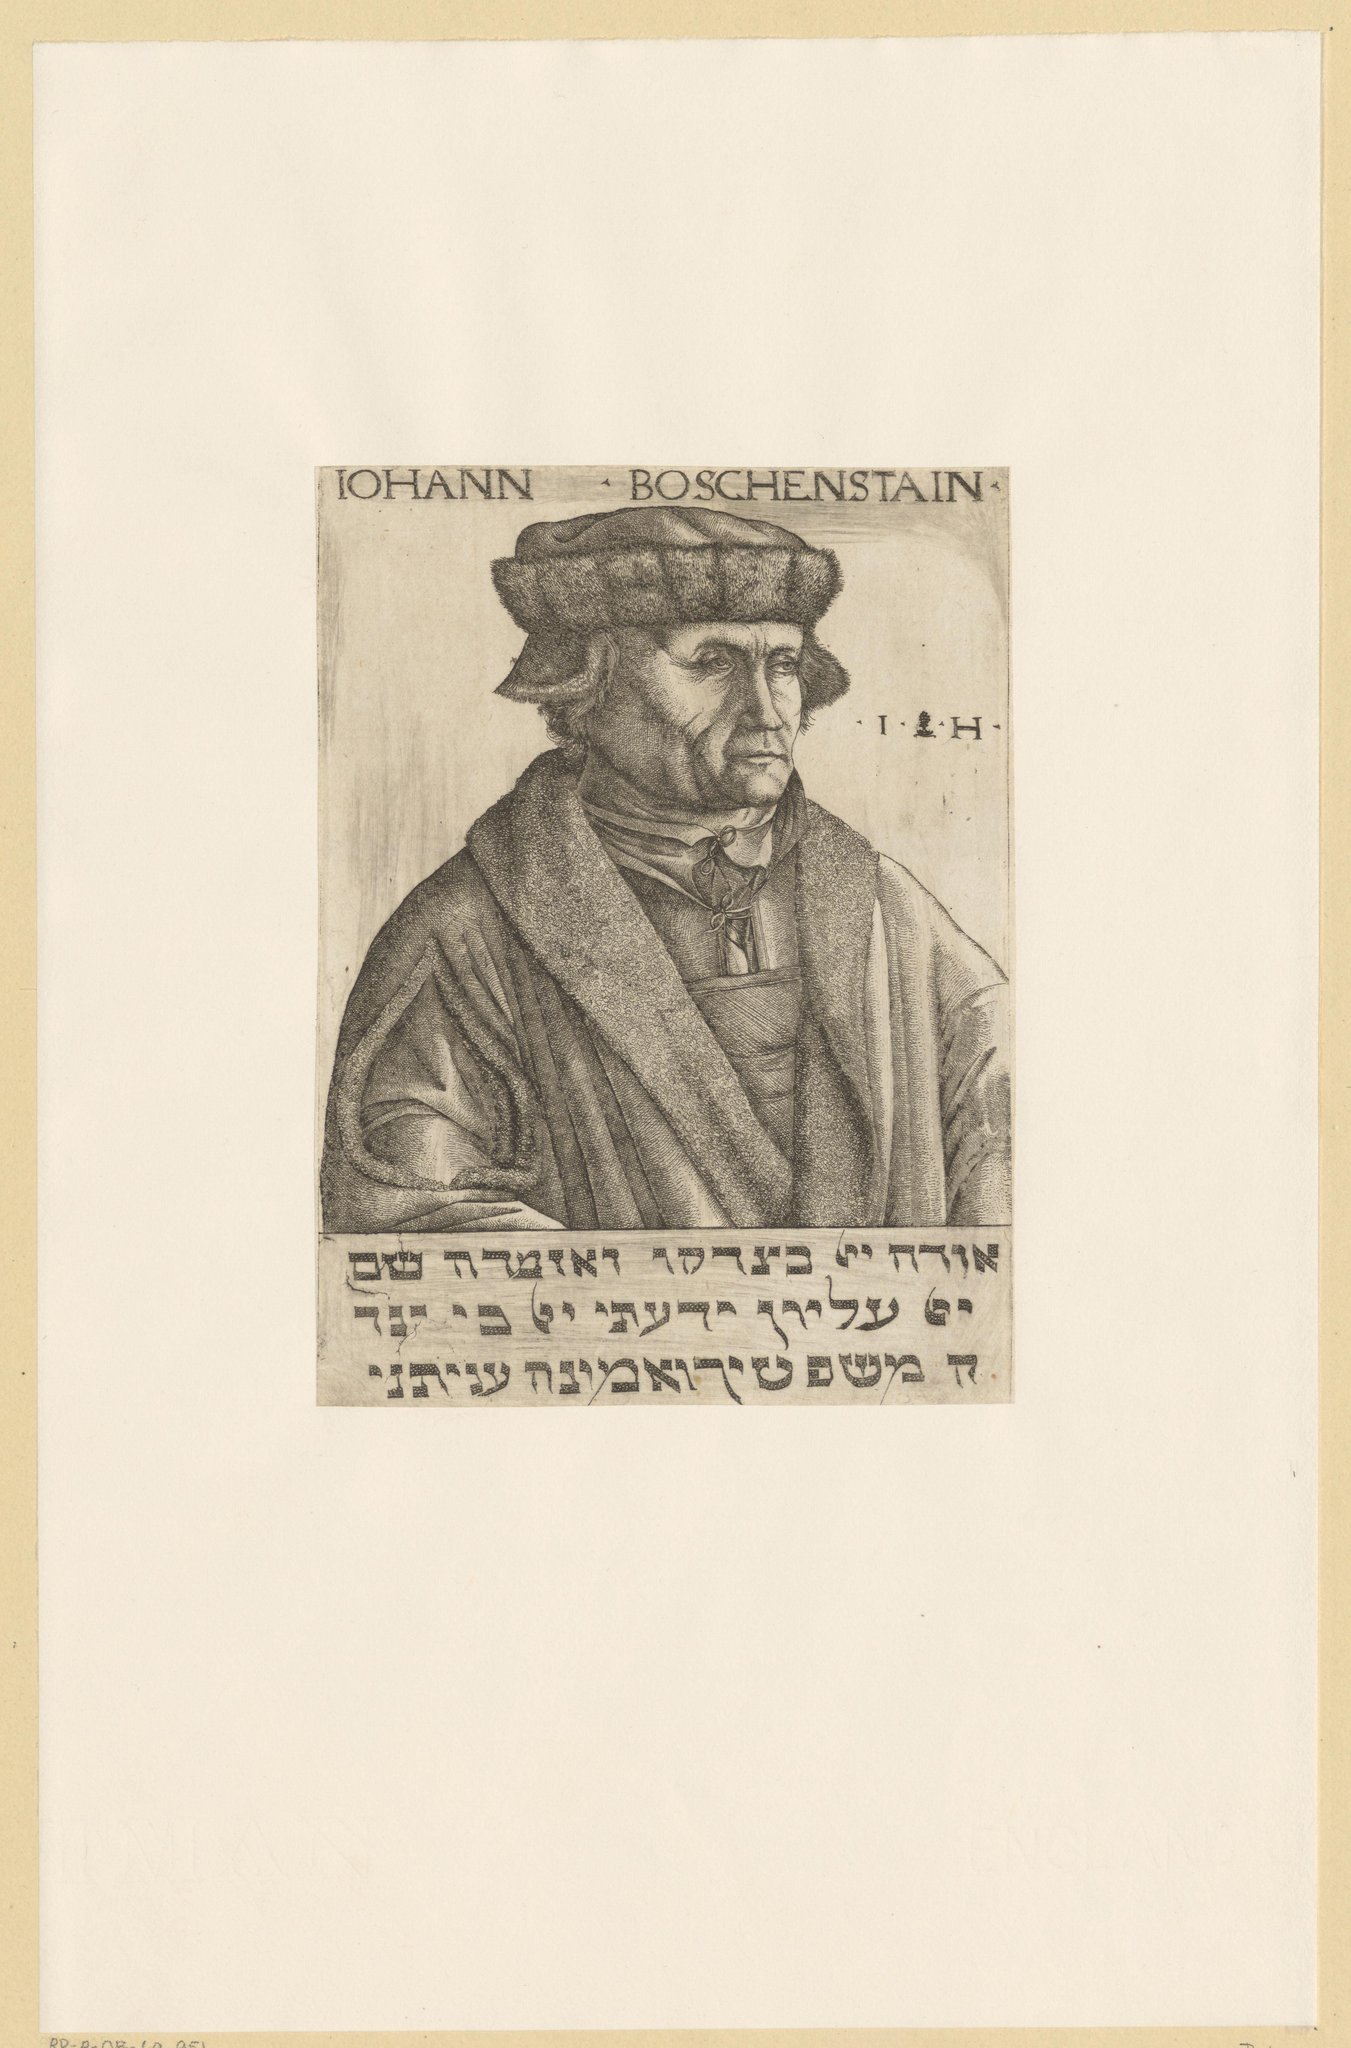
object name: print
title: Portret van Johann Böschenstein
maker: hieronymus hopfer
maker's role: print maker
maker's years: 1500-1550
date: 1510-1550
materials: paper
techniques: etching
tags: hebrew script, historical persons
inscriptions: collector's mark: Lugt 240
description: Portret van Johann Böschenstein (Johann Boschenstain) met tekst in het Hebreeuws in de marge.